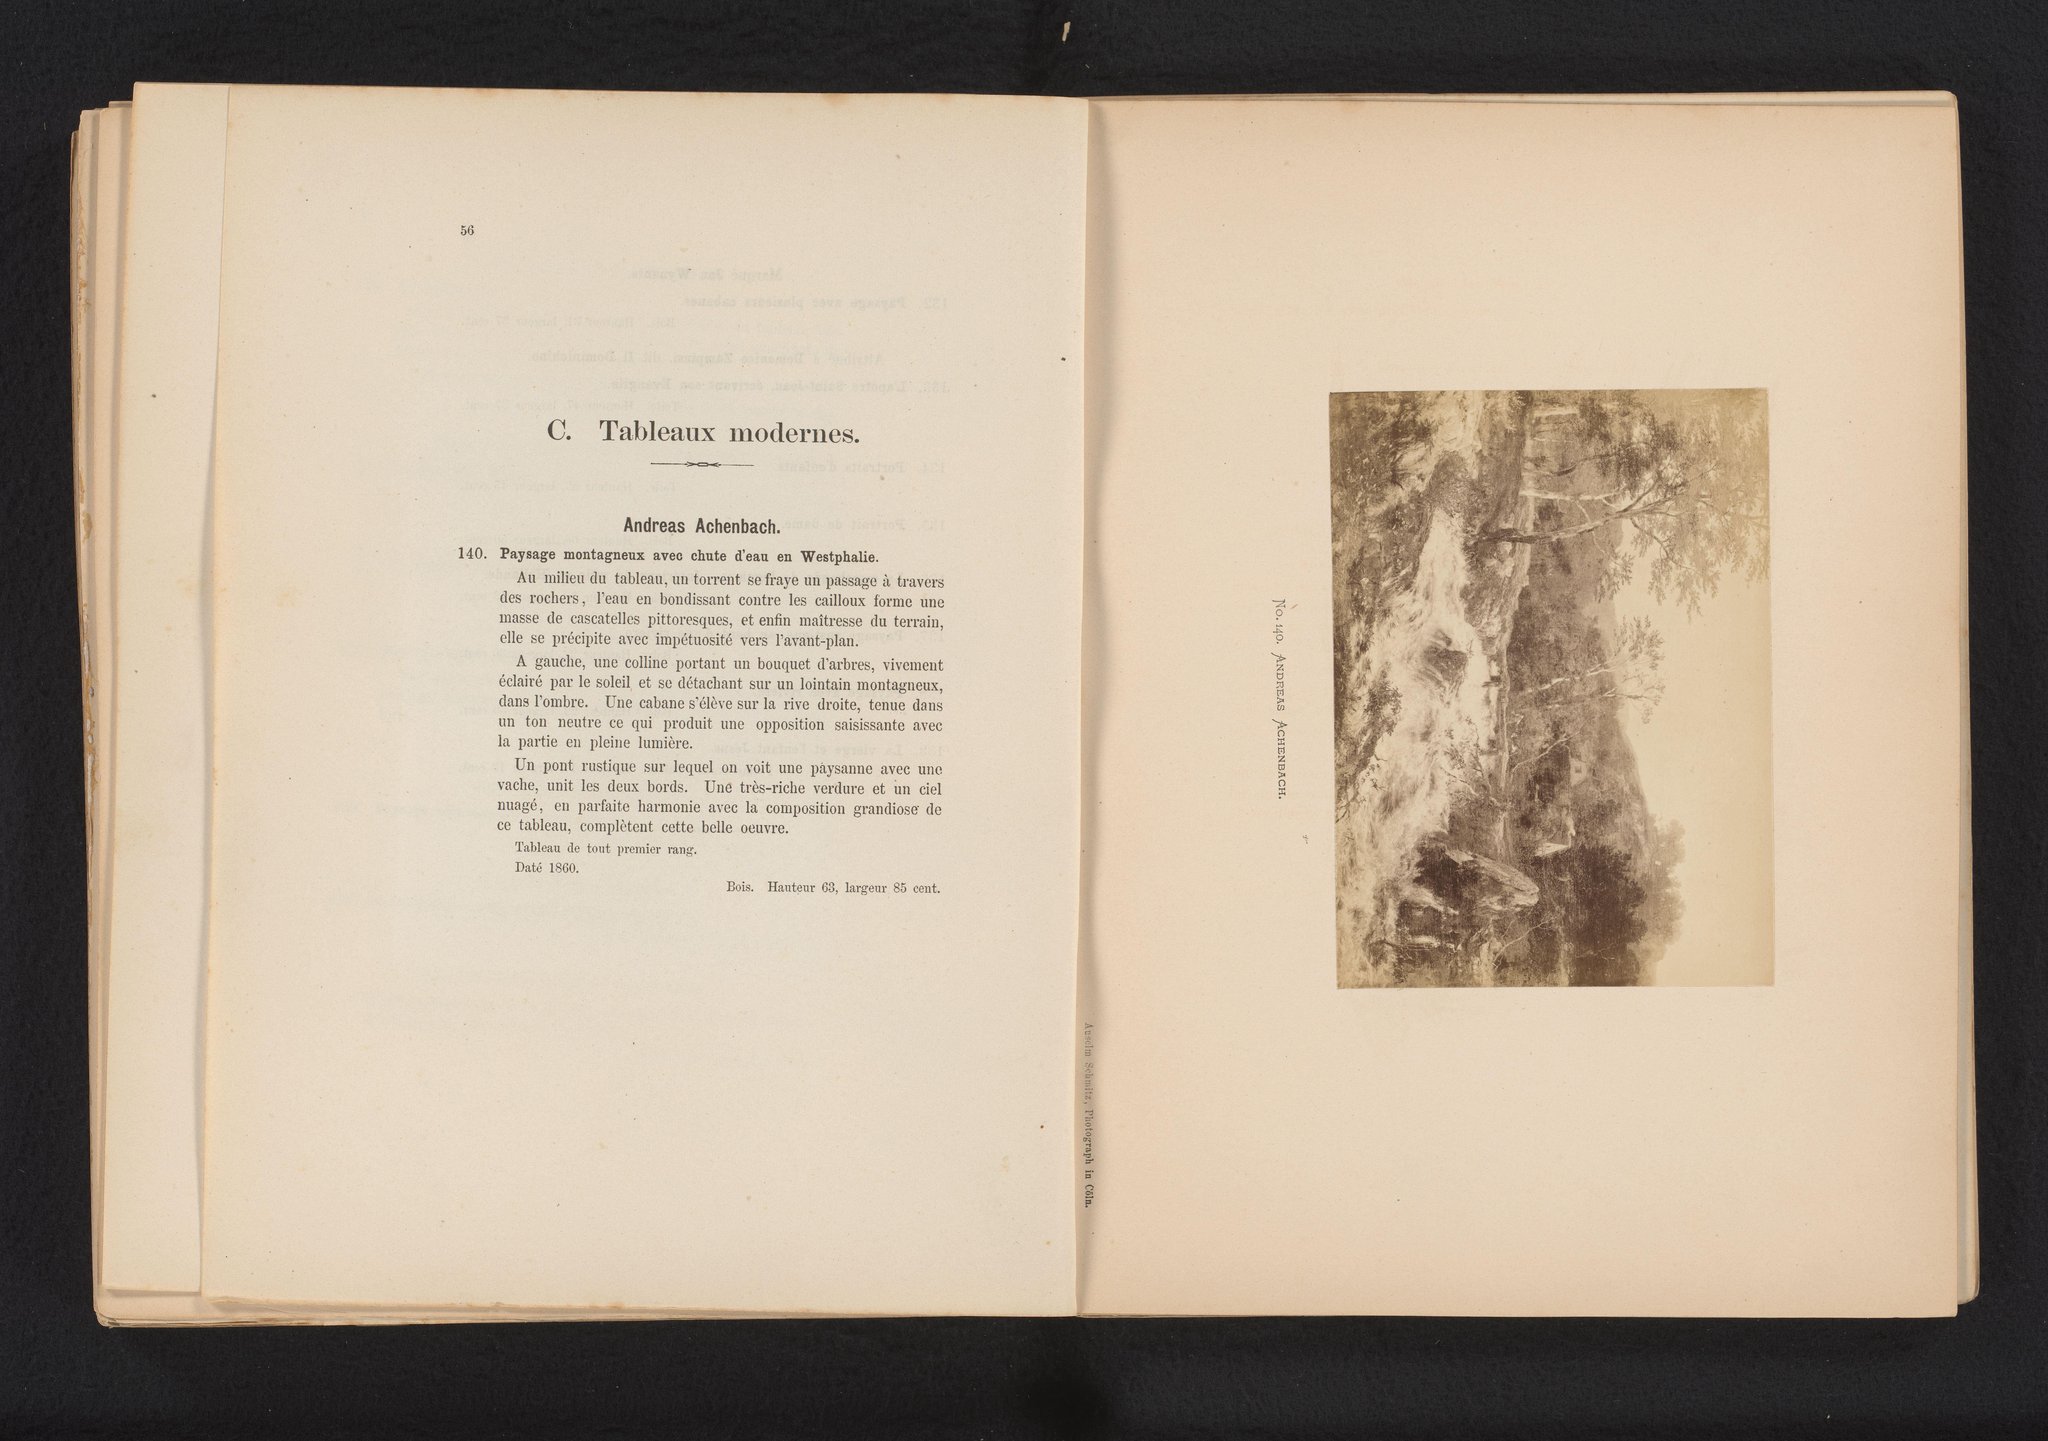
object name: photograph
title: Fotoreproductie van een schilderij van een bergachtig landschap met water in Westfalen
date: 1871-1876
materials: photographic support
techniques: albumen print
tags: waterfall, mountains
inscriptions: inscription: ‘No. 140. Andreas Achenbach’